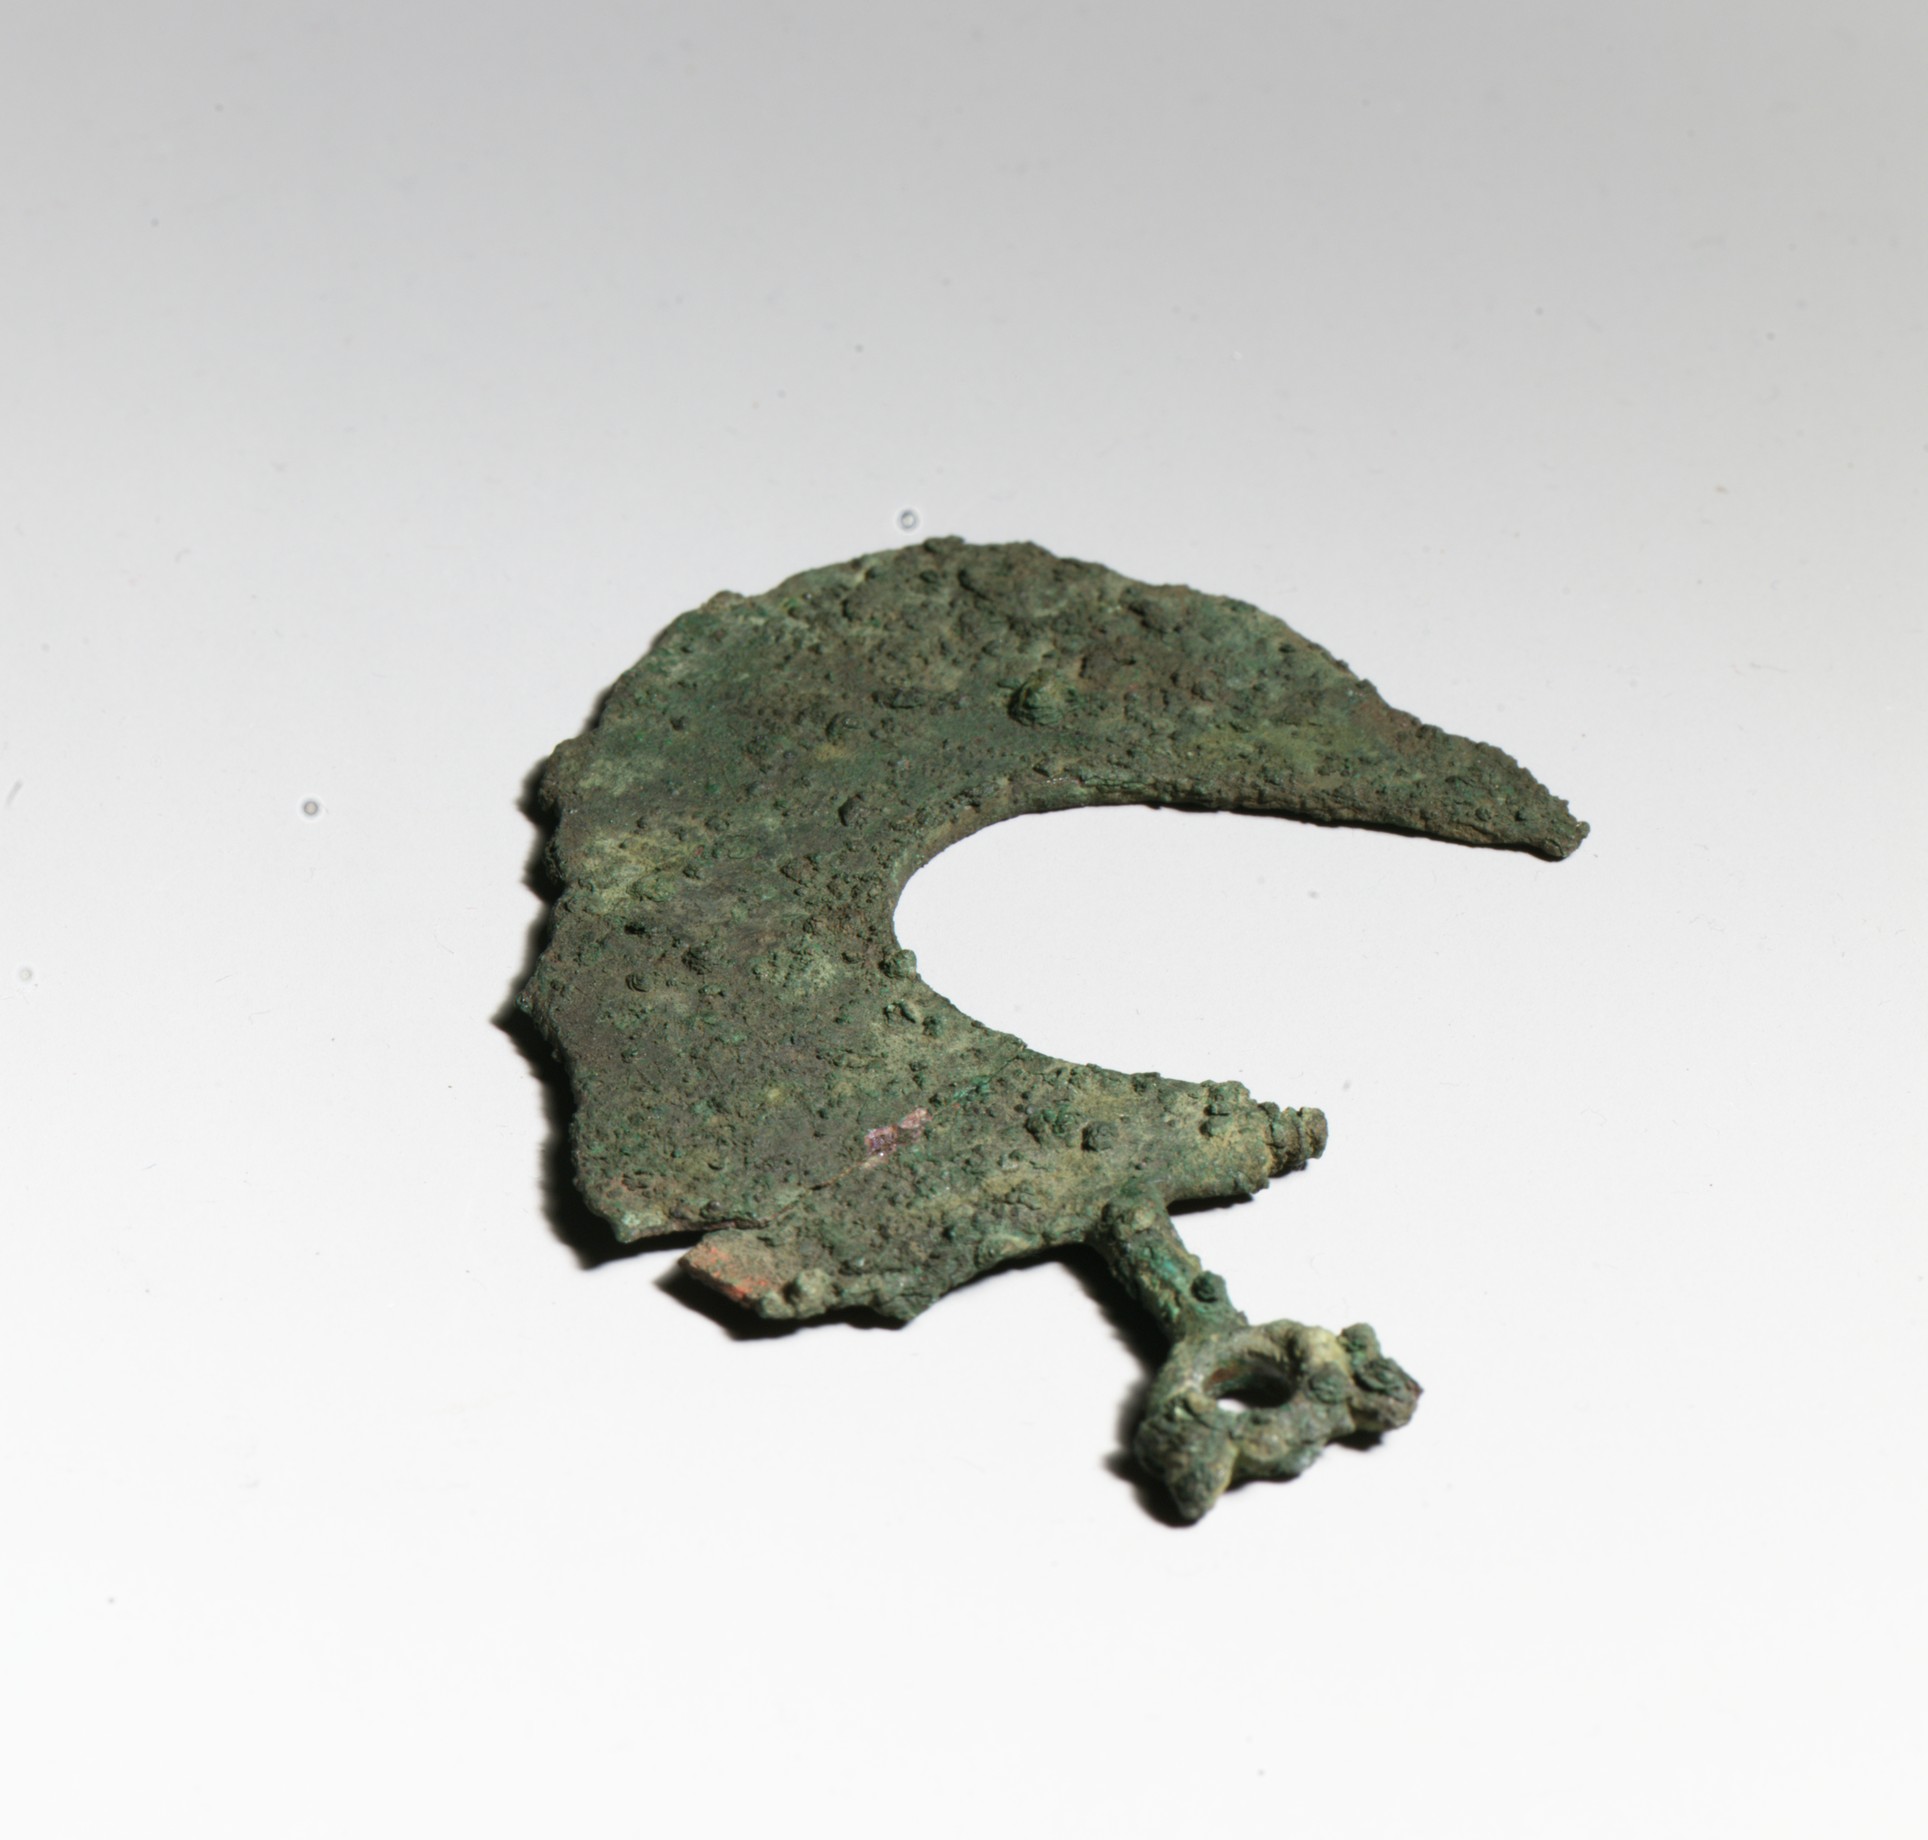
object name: razor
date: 7000 BCE-330 CE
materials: bronze